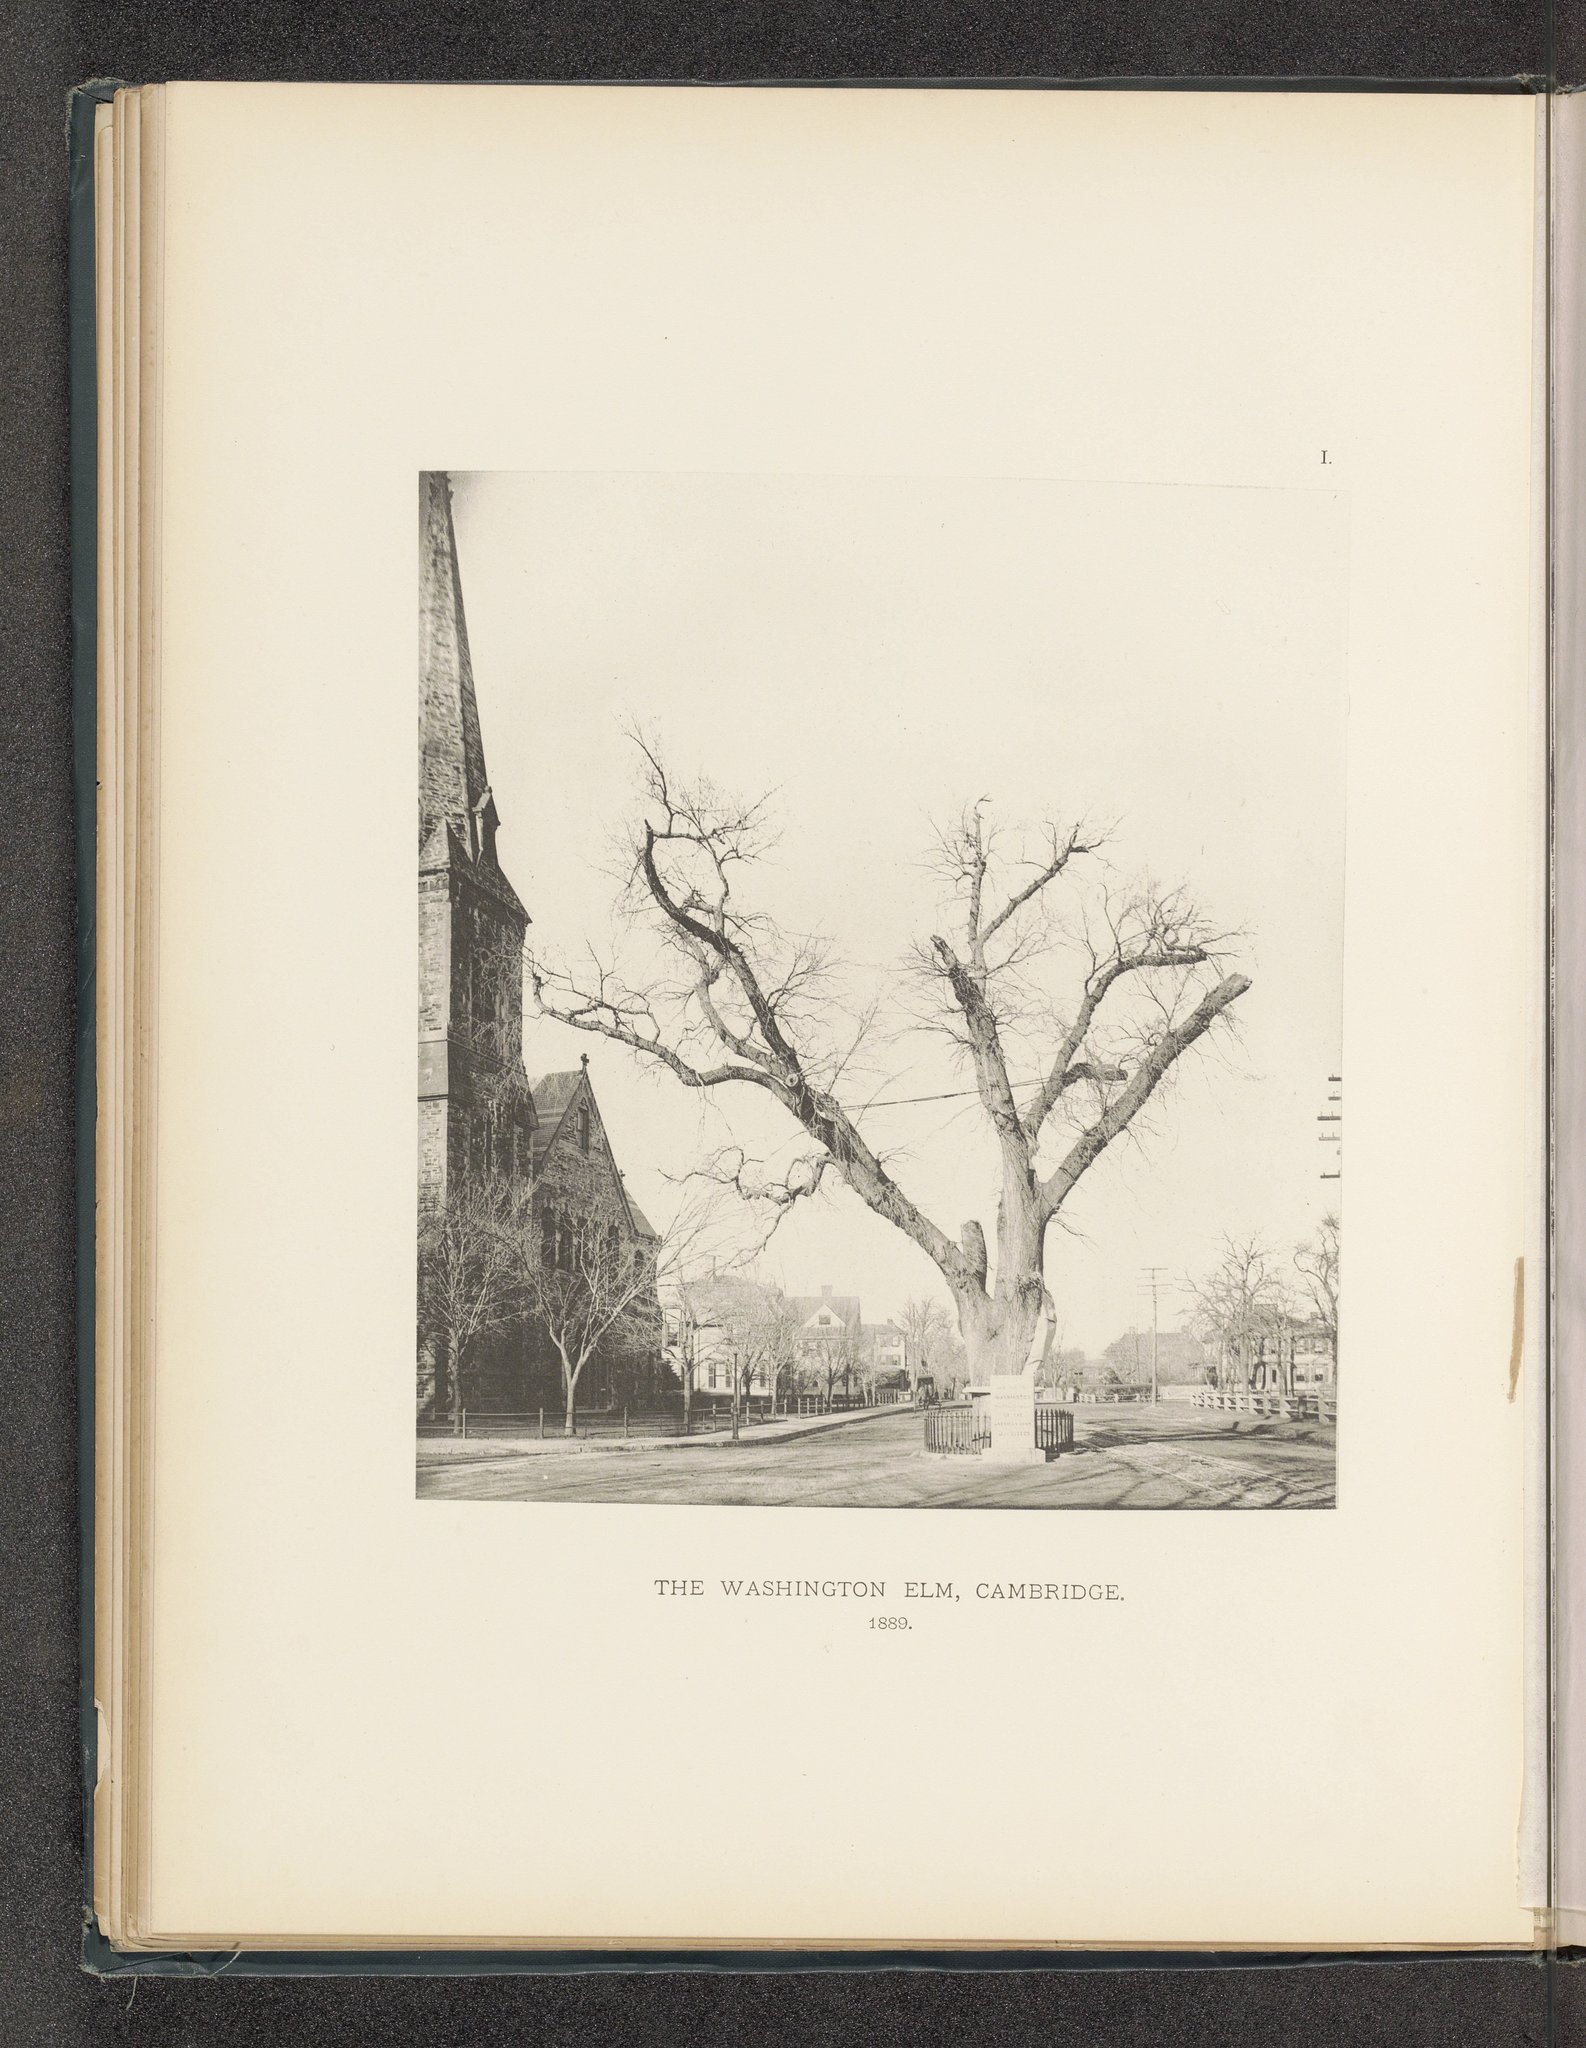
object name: photomechanical print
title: The Washington Elm, Cambridge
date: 1889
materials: paper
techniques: photograph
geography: cambridge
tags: trees: elm, church (exterior)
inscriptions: number: ‘I.’